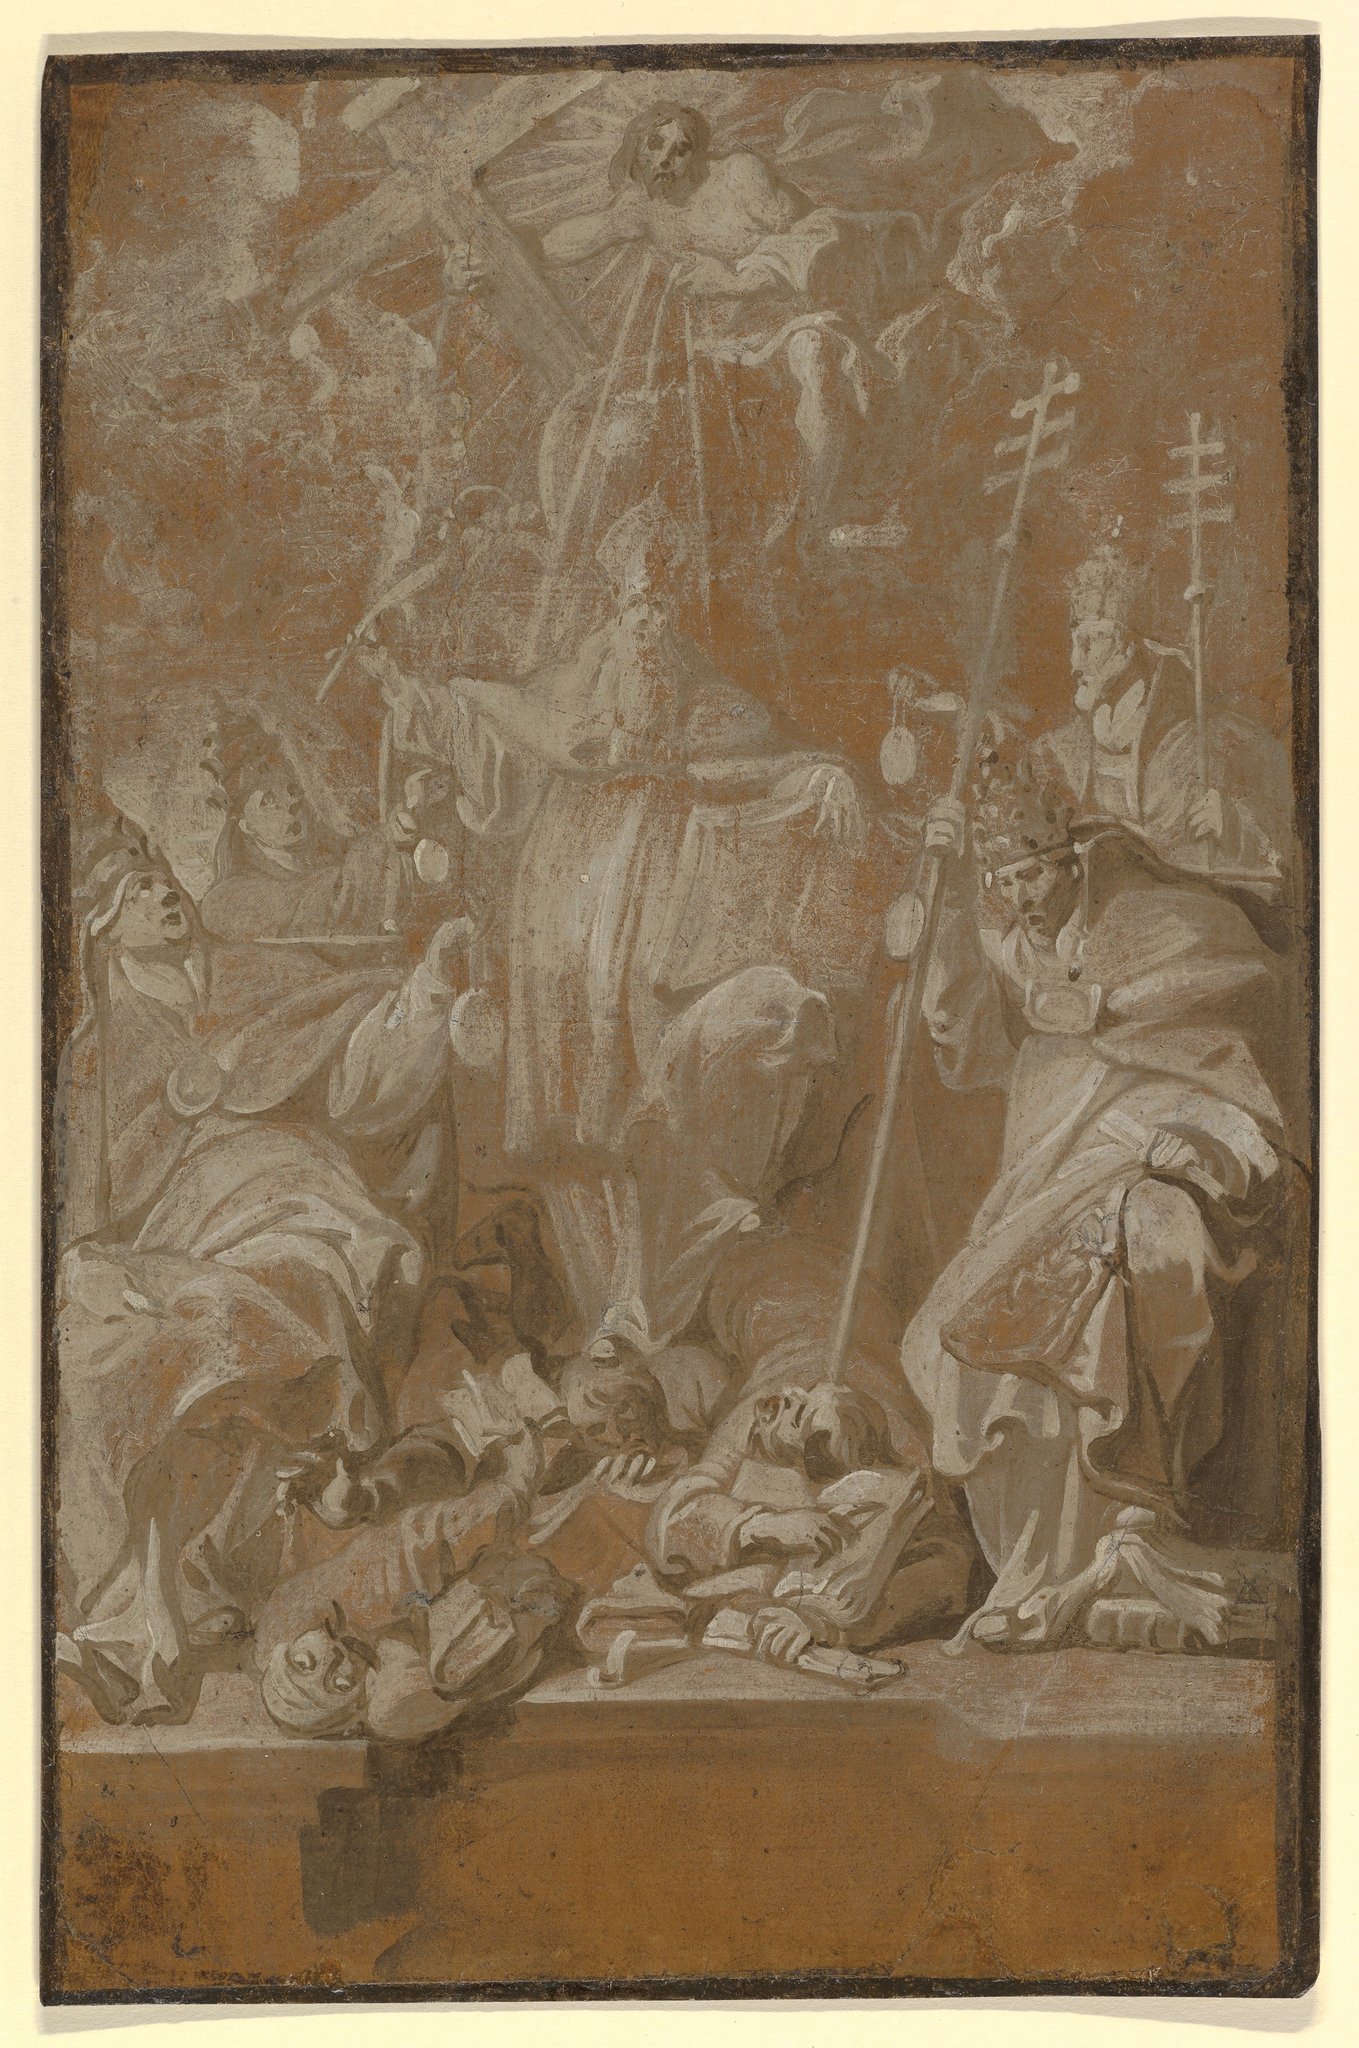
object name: drawing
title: Saint Lambert Trampling his Murderers, Surrounded by the Four Church Fathers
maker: antoine sallaert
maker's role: artist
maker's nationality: flemish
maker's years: 1575-1650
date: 1601-1666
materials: oil, paper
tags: men,cross,jesus,saints,death